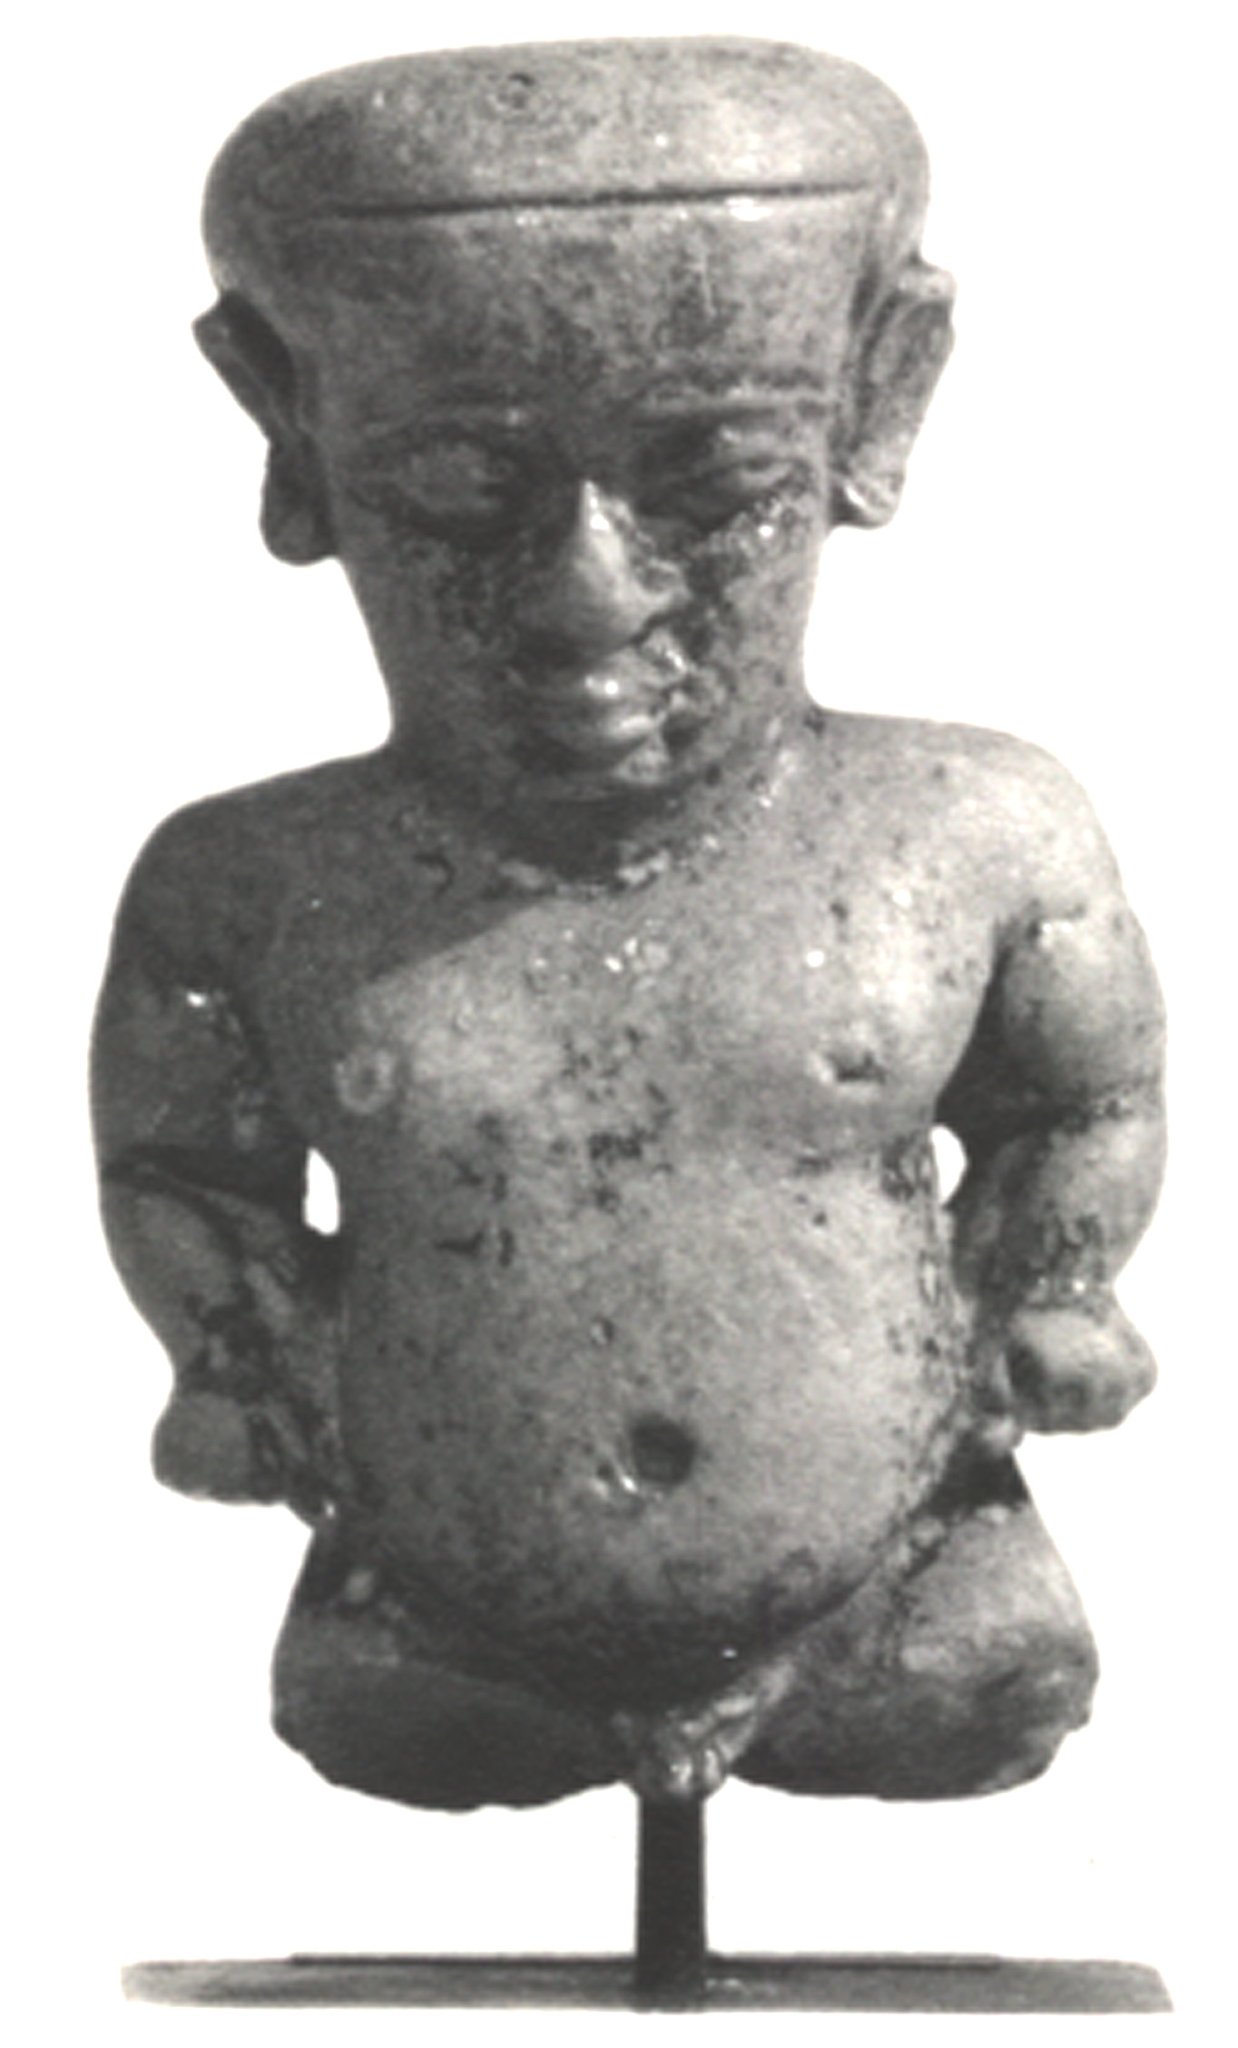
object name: statuette, pataikos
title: Pataikos Figure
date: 712-343 BCE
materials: faience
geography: egypt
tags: goddess